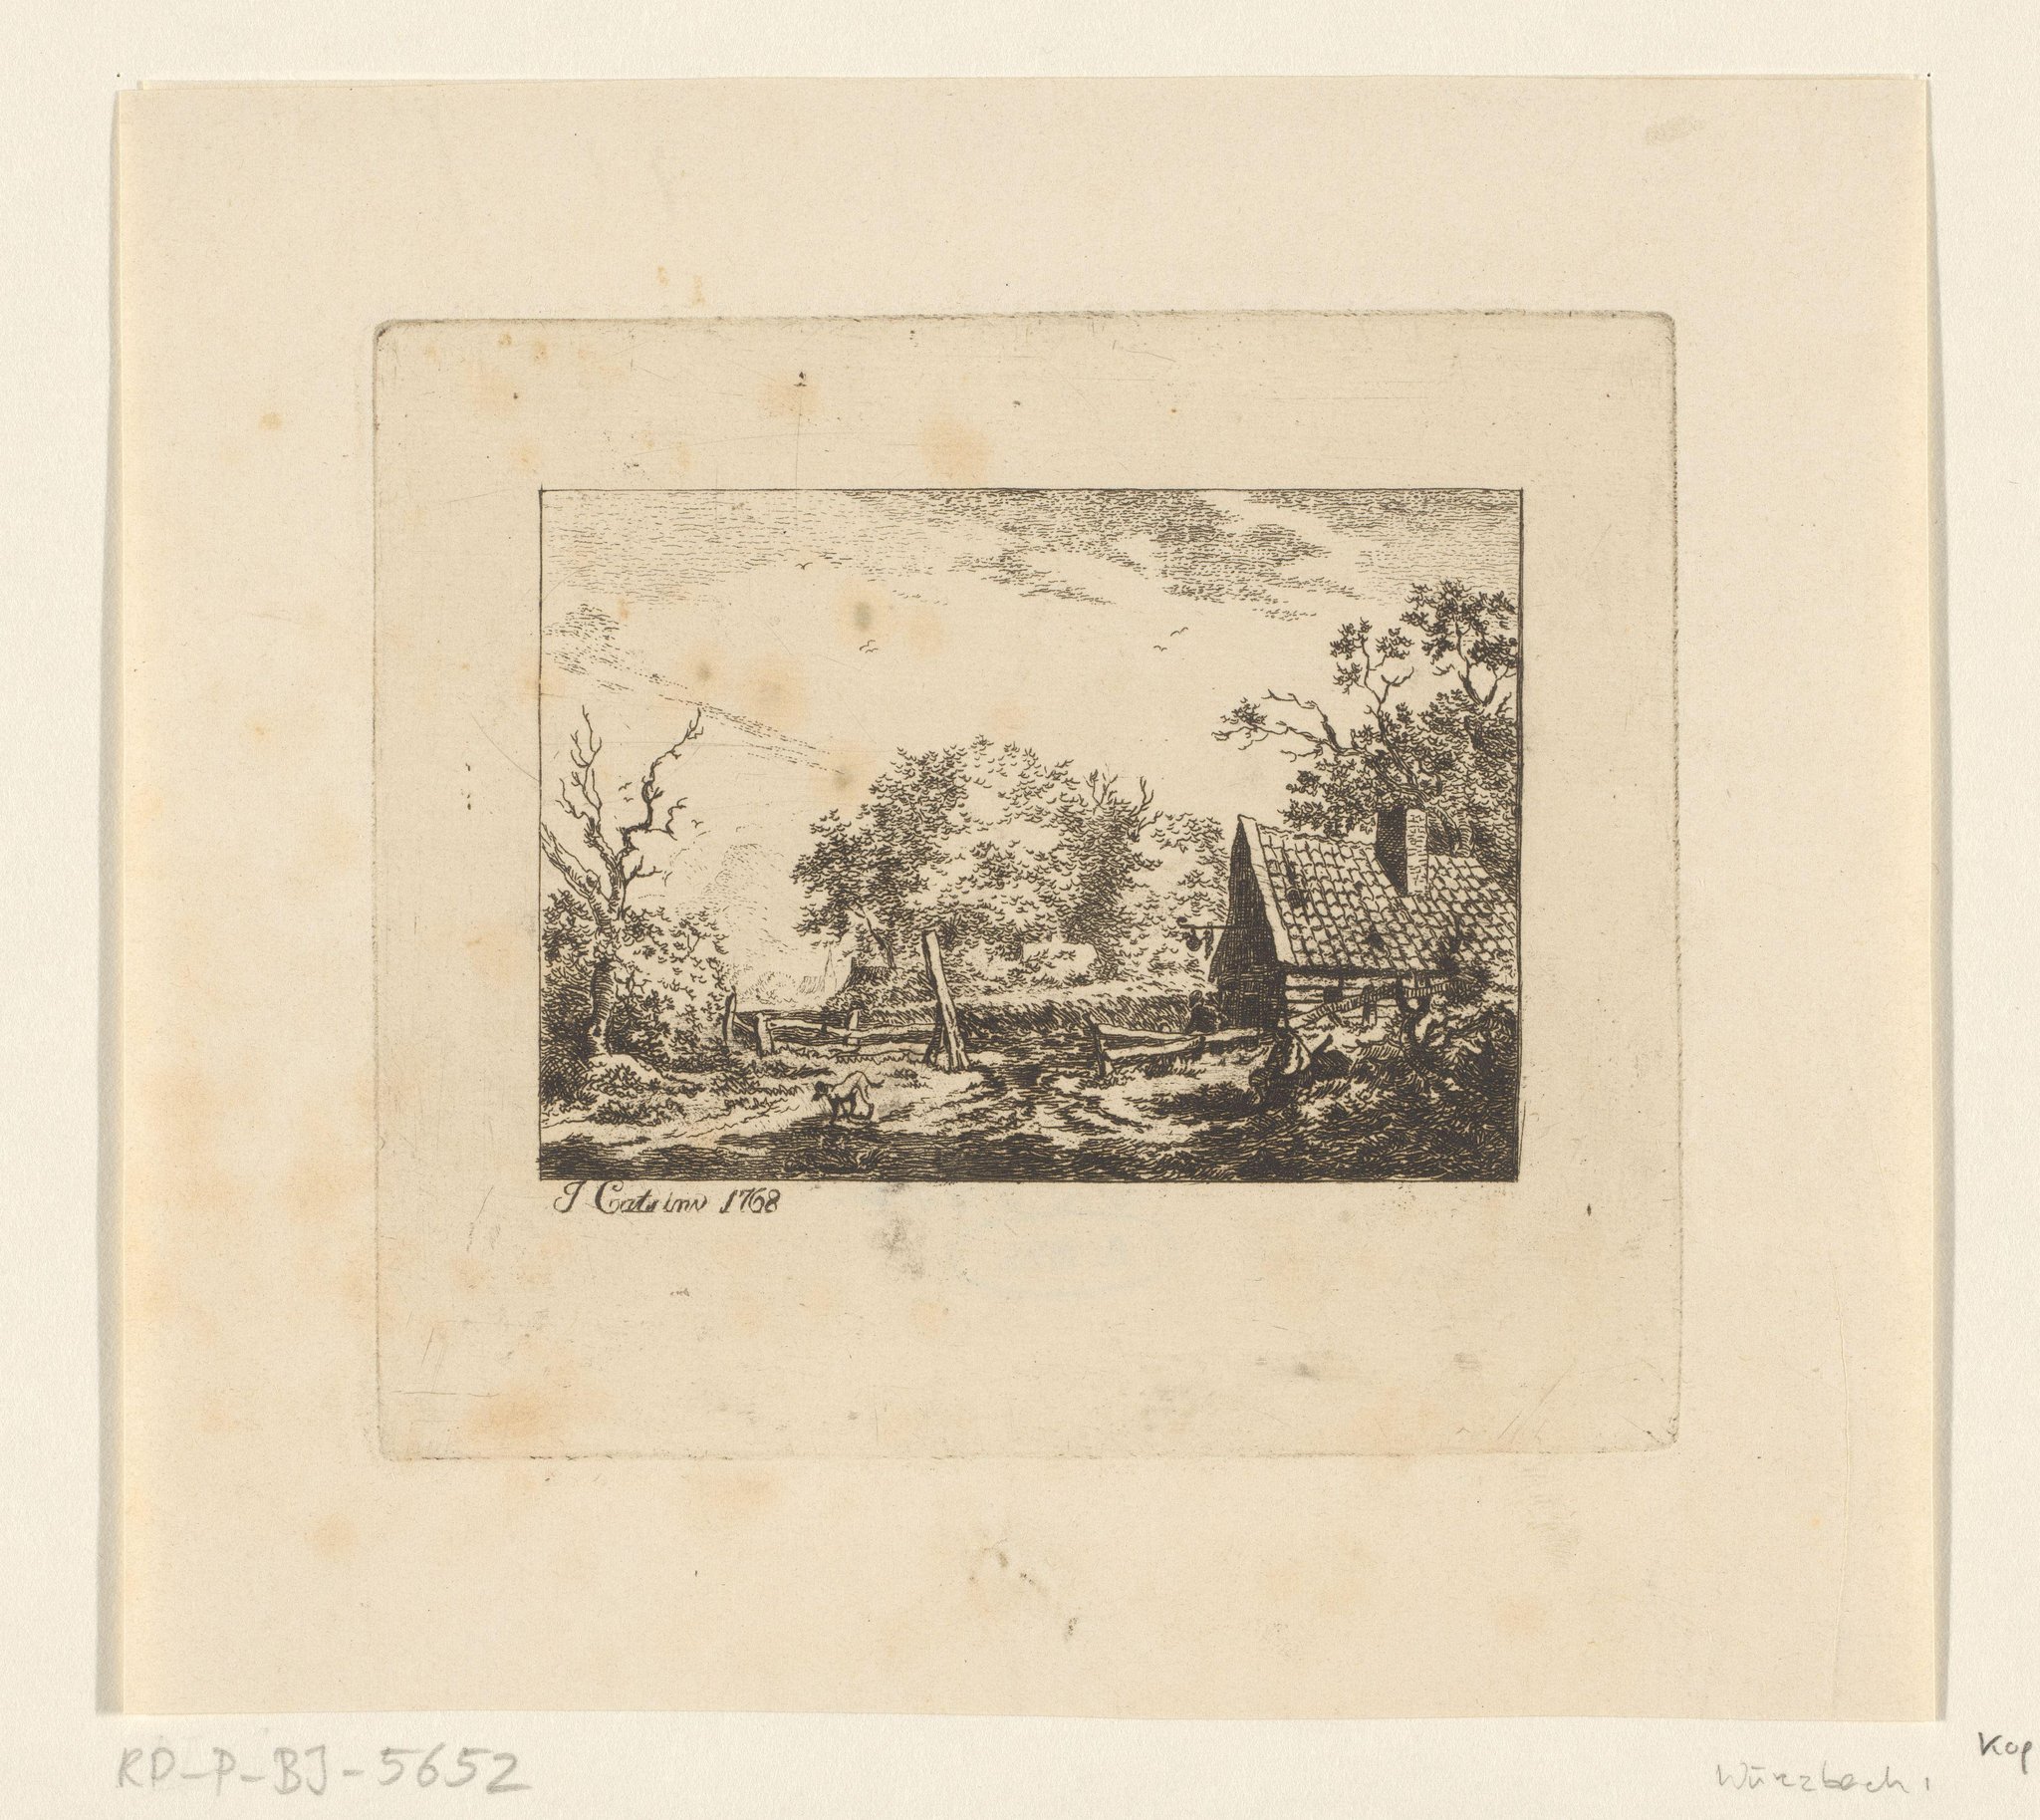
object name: print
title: Landschap met zittende man en hond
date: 1768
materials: paper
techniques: etching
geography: amsterdam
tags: landscapes, dog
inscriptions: collector's mark: Lugt 2228